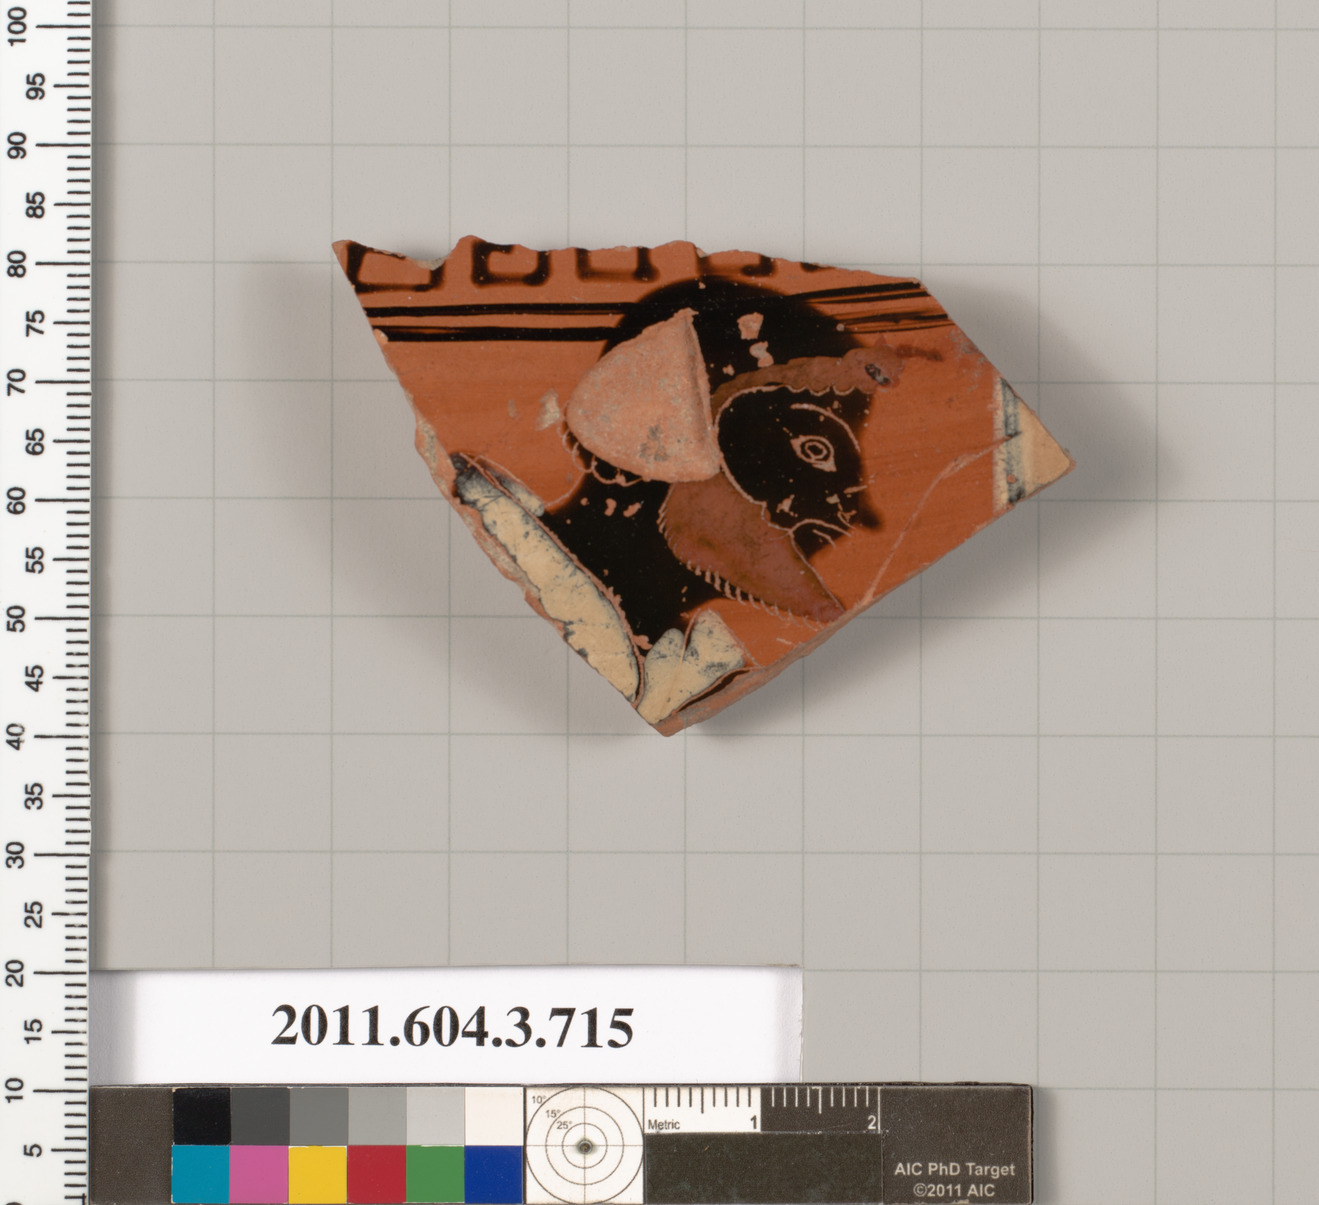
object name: hydria fragment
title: Terracotta fragment of a hydria (water jar)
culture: greek, attic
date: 550-526 BCE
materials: terracotta